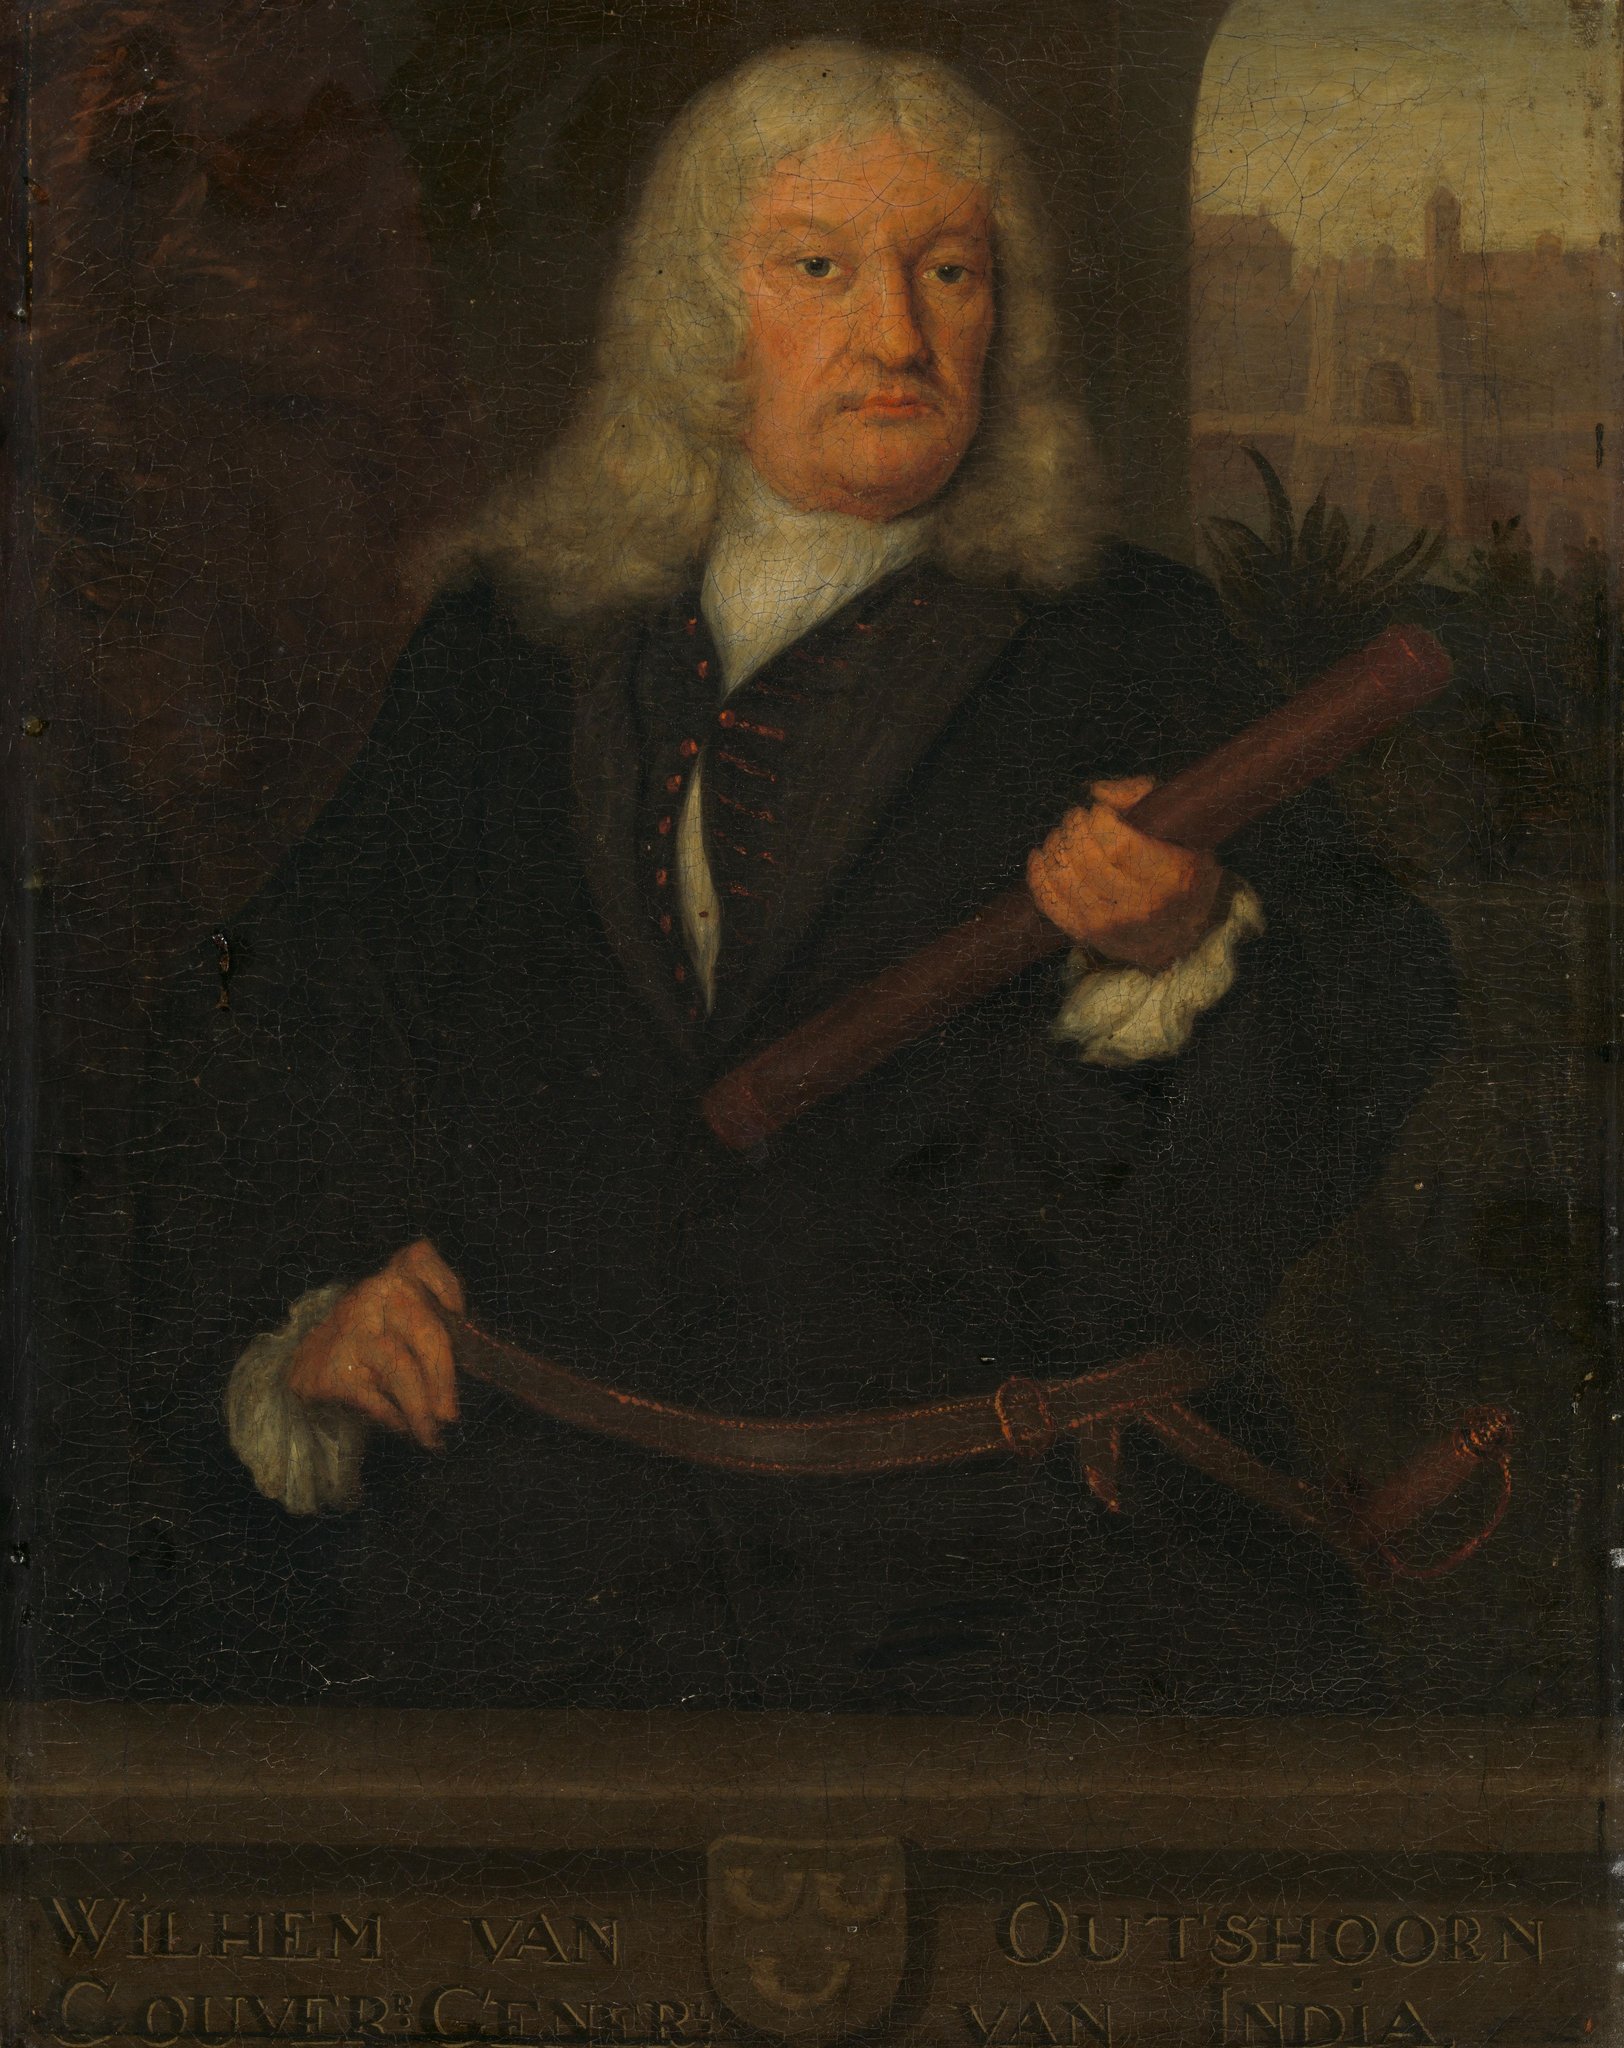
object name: painting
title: Portrait of Willem van Outhoorn, Governor General of the Dutch East Indies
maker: david van der plas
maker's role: draughtsman, painter, print maker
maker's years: 1647-1704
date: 1691-1704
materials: canvas, oil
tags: batavia, willem van outhoorn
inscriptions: signature: ‘D. vr Plaes’, inscription: ‘Wilhem van Outshoorn, Gouver.r Gener.l van India.’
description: Portraits of the governors general. At the head of the VOC administration in Asia was the governor general, the chairman of the East Indies Council, which met in Batavia. The Council's assembly chamber at the Castle in Batavia was the focal point of Dutch power. Along the walls hung the portraits of all the past governors general, symbolising the continuity of the Dutch presence. Smaller copies at the Company's offices in the Netherlands represented the VOC's power in Asia. The copies displayed here probably come from the VOC's Rotterdam Chamber. Some of the portraits from the series that hung in Batavia are displayed above in the VOC gallery that circles this room. Pieter Both, 1610-1614 Gerard Reynst, 1614-1615 Laurens Reael,1615-1619 Jan Pietersz Coen, 1619-1623 and 1627-1629 Pieter de Carpentier, 1623-1627 Jacques Specx, 1629-1632 Hendrick Brouwer, 1632-1636 Antonio van Diemen, 1636-1645 Cornelis van der Lijn, 1645-1650 Karel Reiniersz, 1650-1653 Joan Maetsuycker, 1653-1678 Rycklof van Goens, 1678-1681 Cornelis Speelman, 1681-1684 Johannes Camphuys, 1684-1691 Willem van Outshoorn, 1691-1704 Abraham van Riebeeck, 1709-1713 Christoffel van Swoll, 1713-1718 Hendrick Zwaardecroon, 1718-1725 Mattheus de Haan, 1725-1729 The portrait of Joan van Hoorn, 1704-1709, is missing.